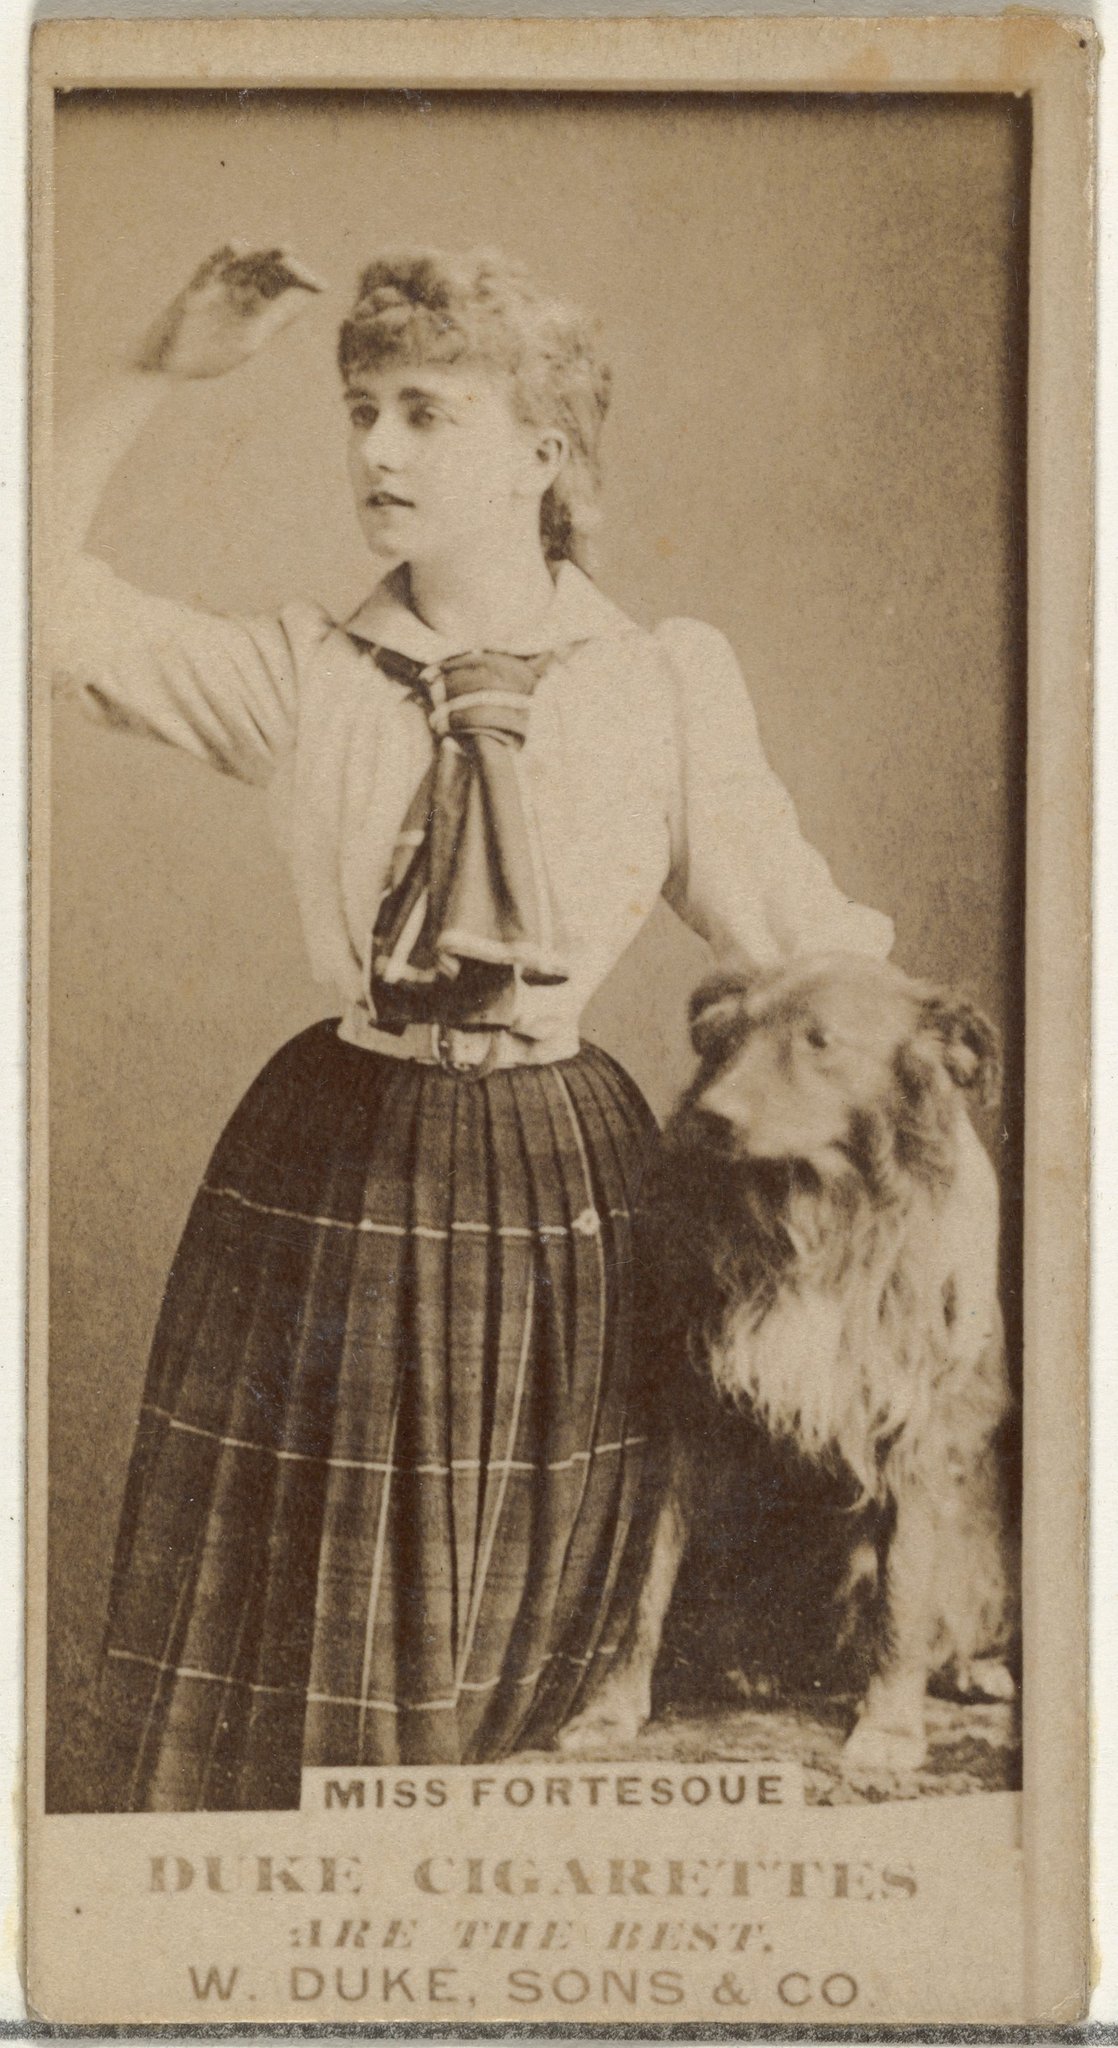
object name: photograph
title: Miss Fortesque, from the Actors and Actresses series (N145-7) issued by Duke Sons & Co. to promote Duke Cigarettes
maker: w. duke, sons & co.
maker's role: publisher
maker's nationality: american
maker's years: 1870-1920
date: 1880-1889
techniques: albumen silver print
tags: portraits,women,dogs,actresses